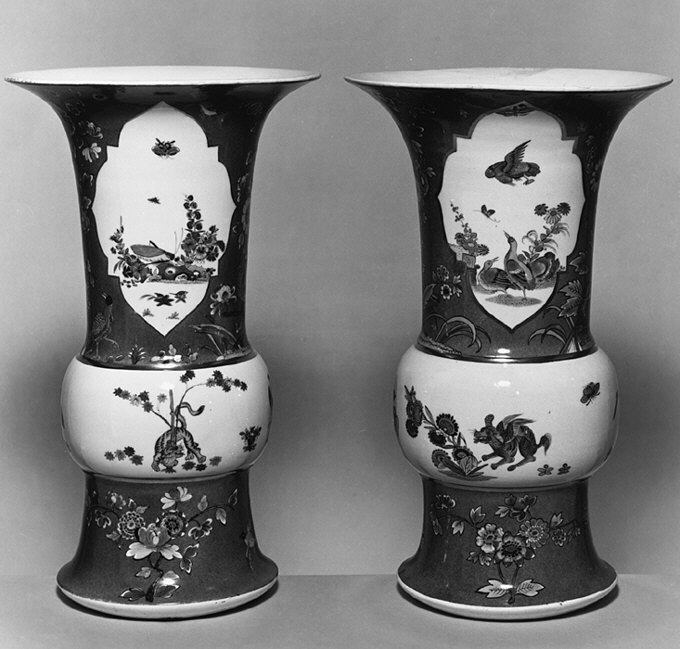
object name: beaker vase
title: Pair of beaker vases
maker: meissen manufactory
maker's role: manufactory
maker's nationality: german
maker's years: 1710-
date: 1730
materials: hard paste porcelain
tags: birds,insects